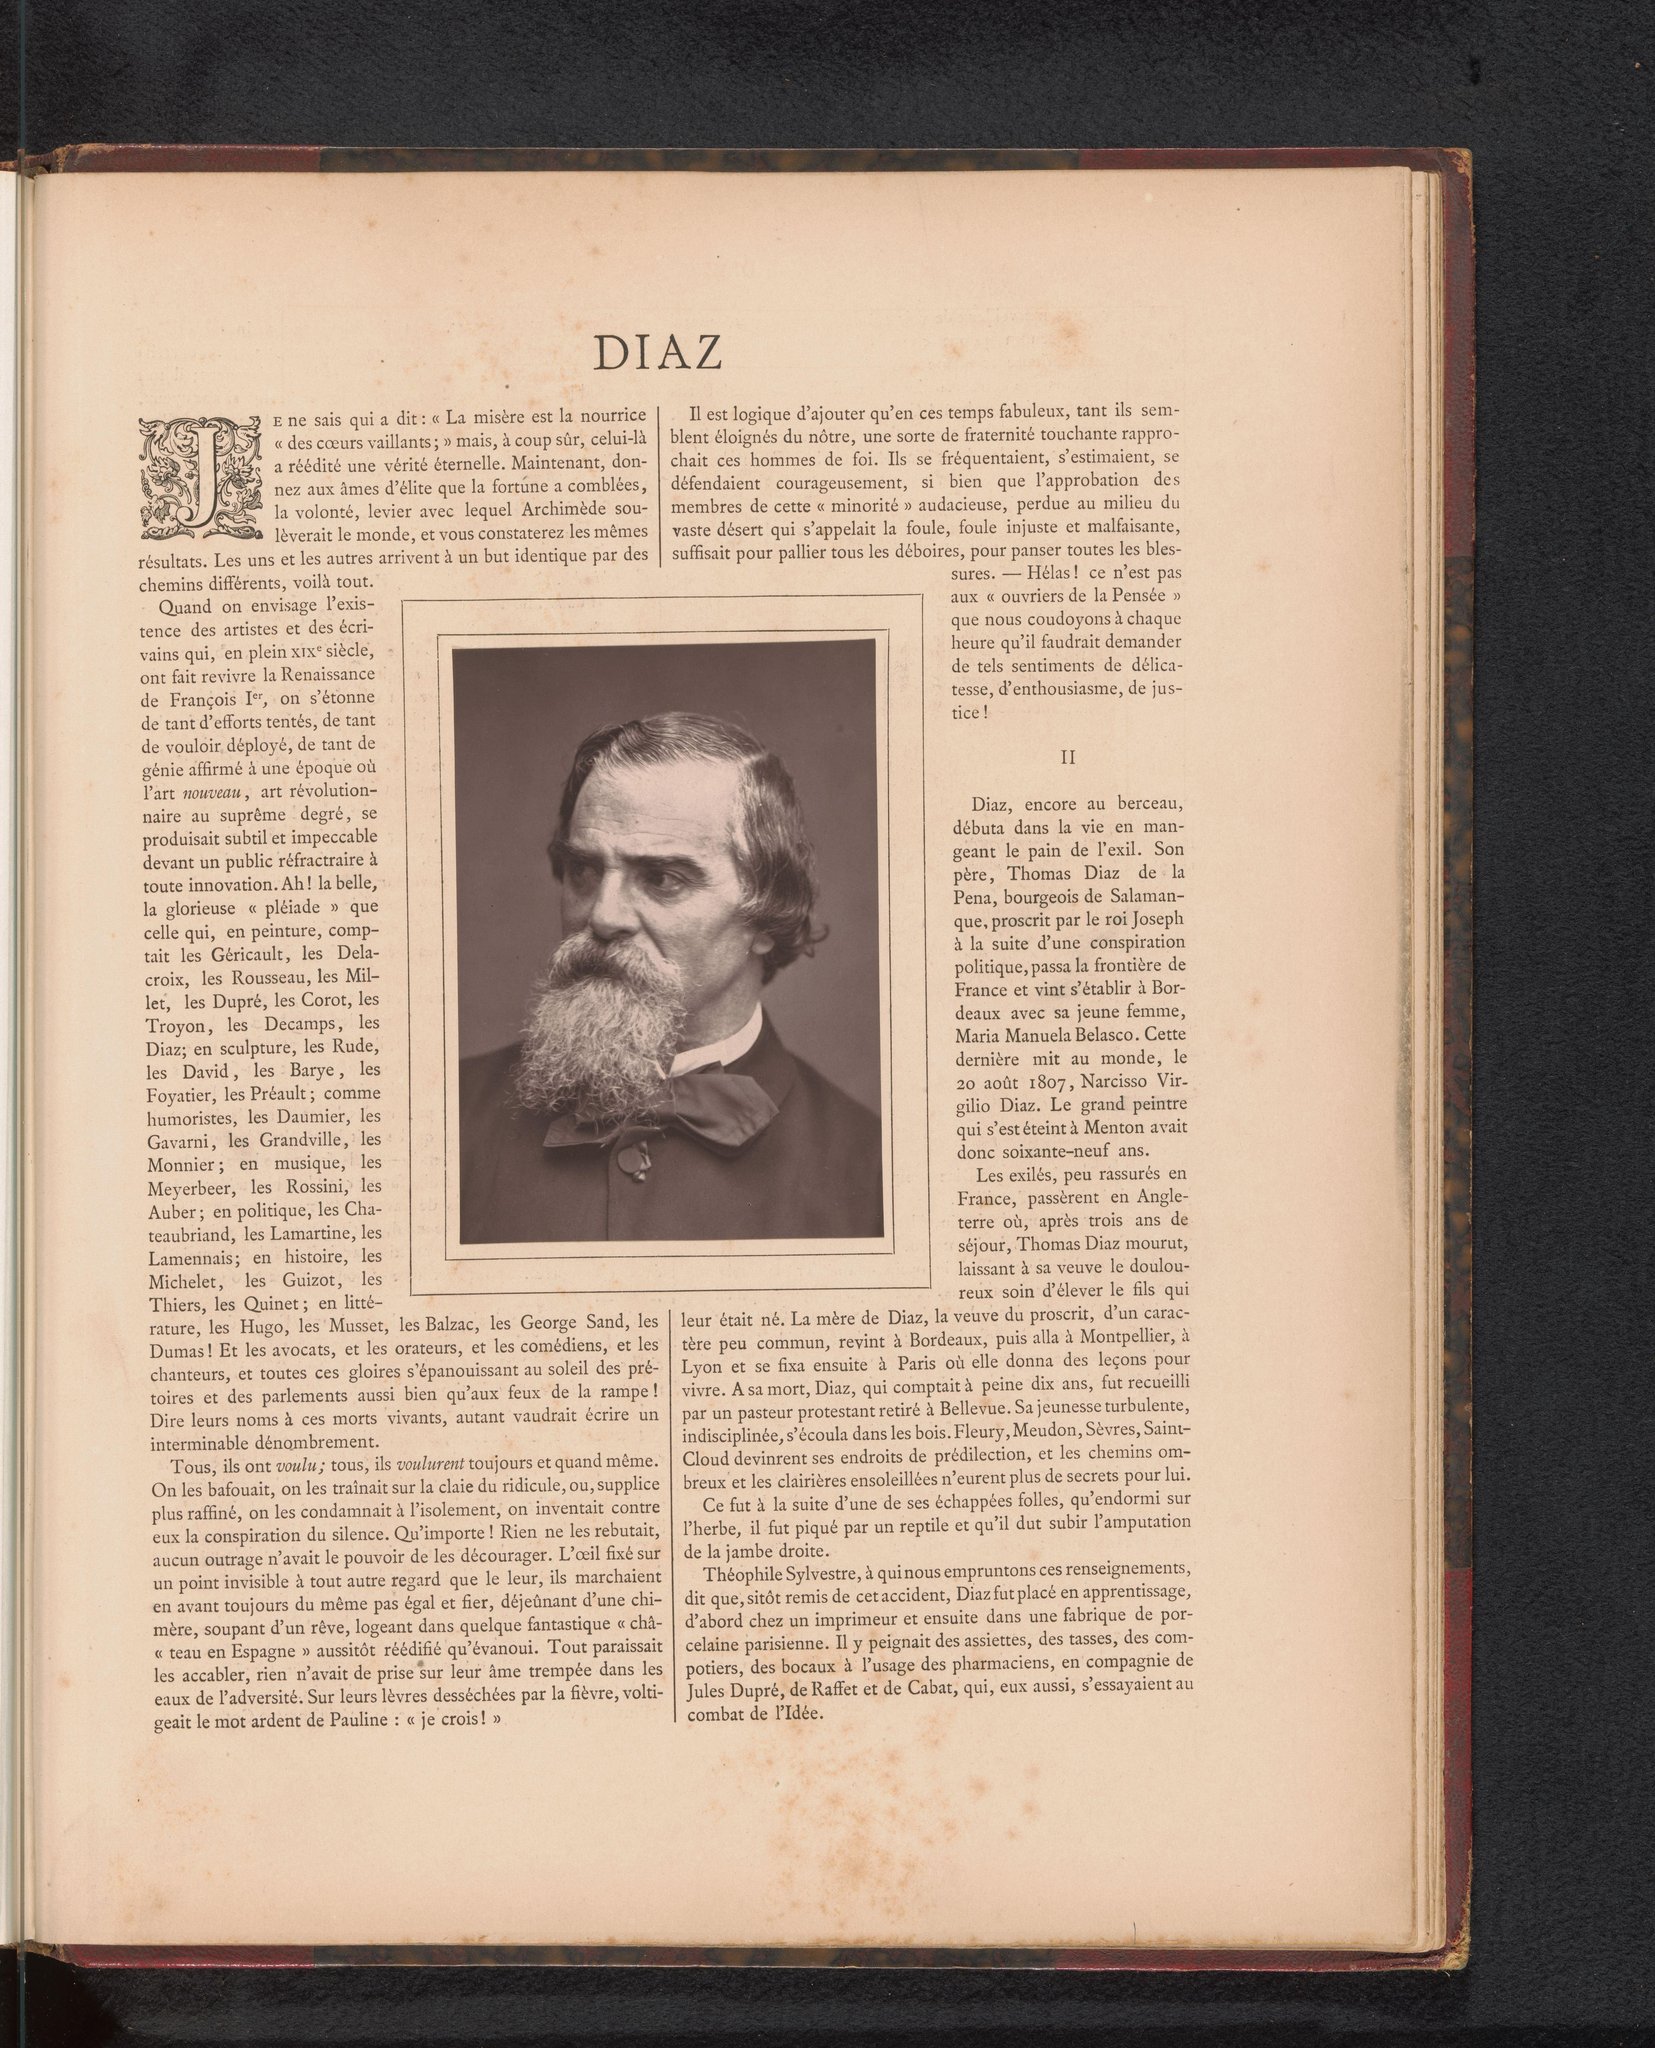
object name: page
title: Portret van Narcisse Virgile Diaz de la Peña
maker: Anonymous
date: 1873-1878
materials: paper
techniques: woodburytype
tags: painter, print maker, draughtsman, narcisse virgile diaz de la peña, historical persons, portrait, self-portrait of painter